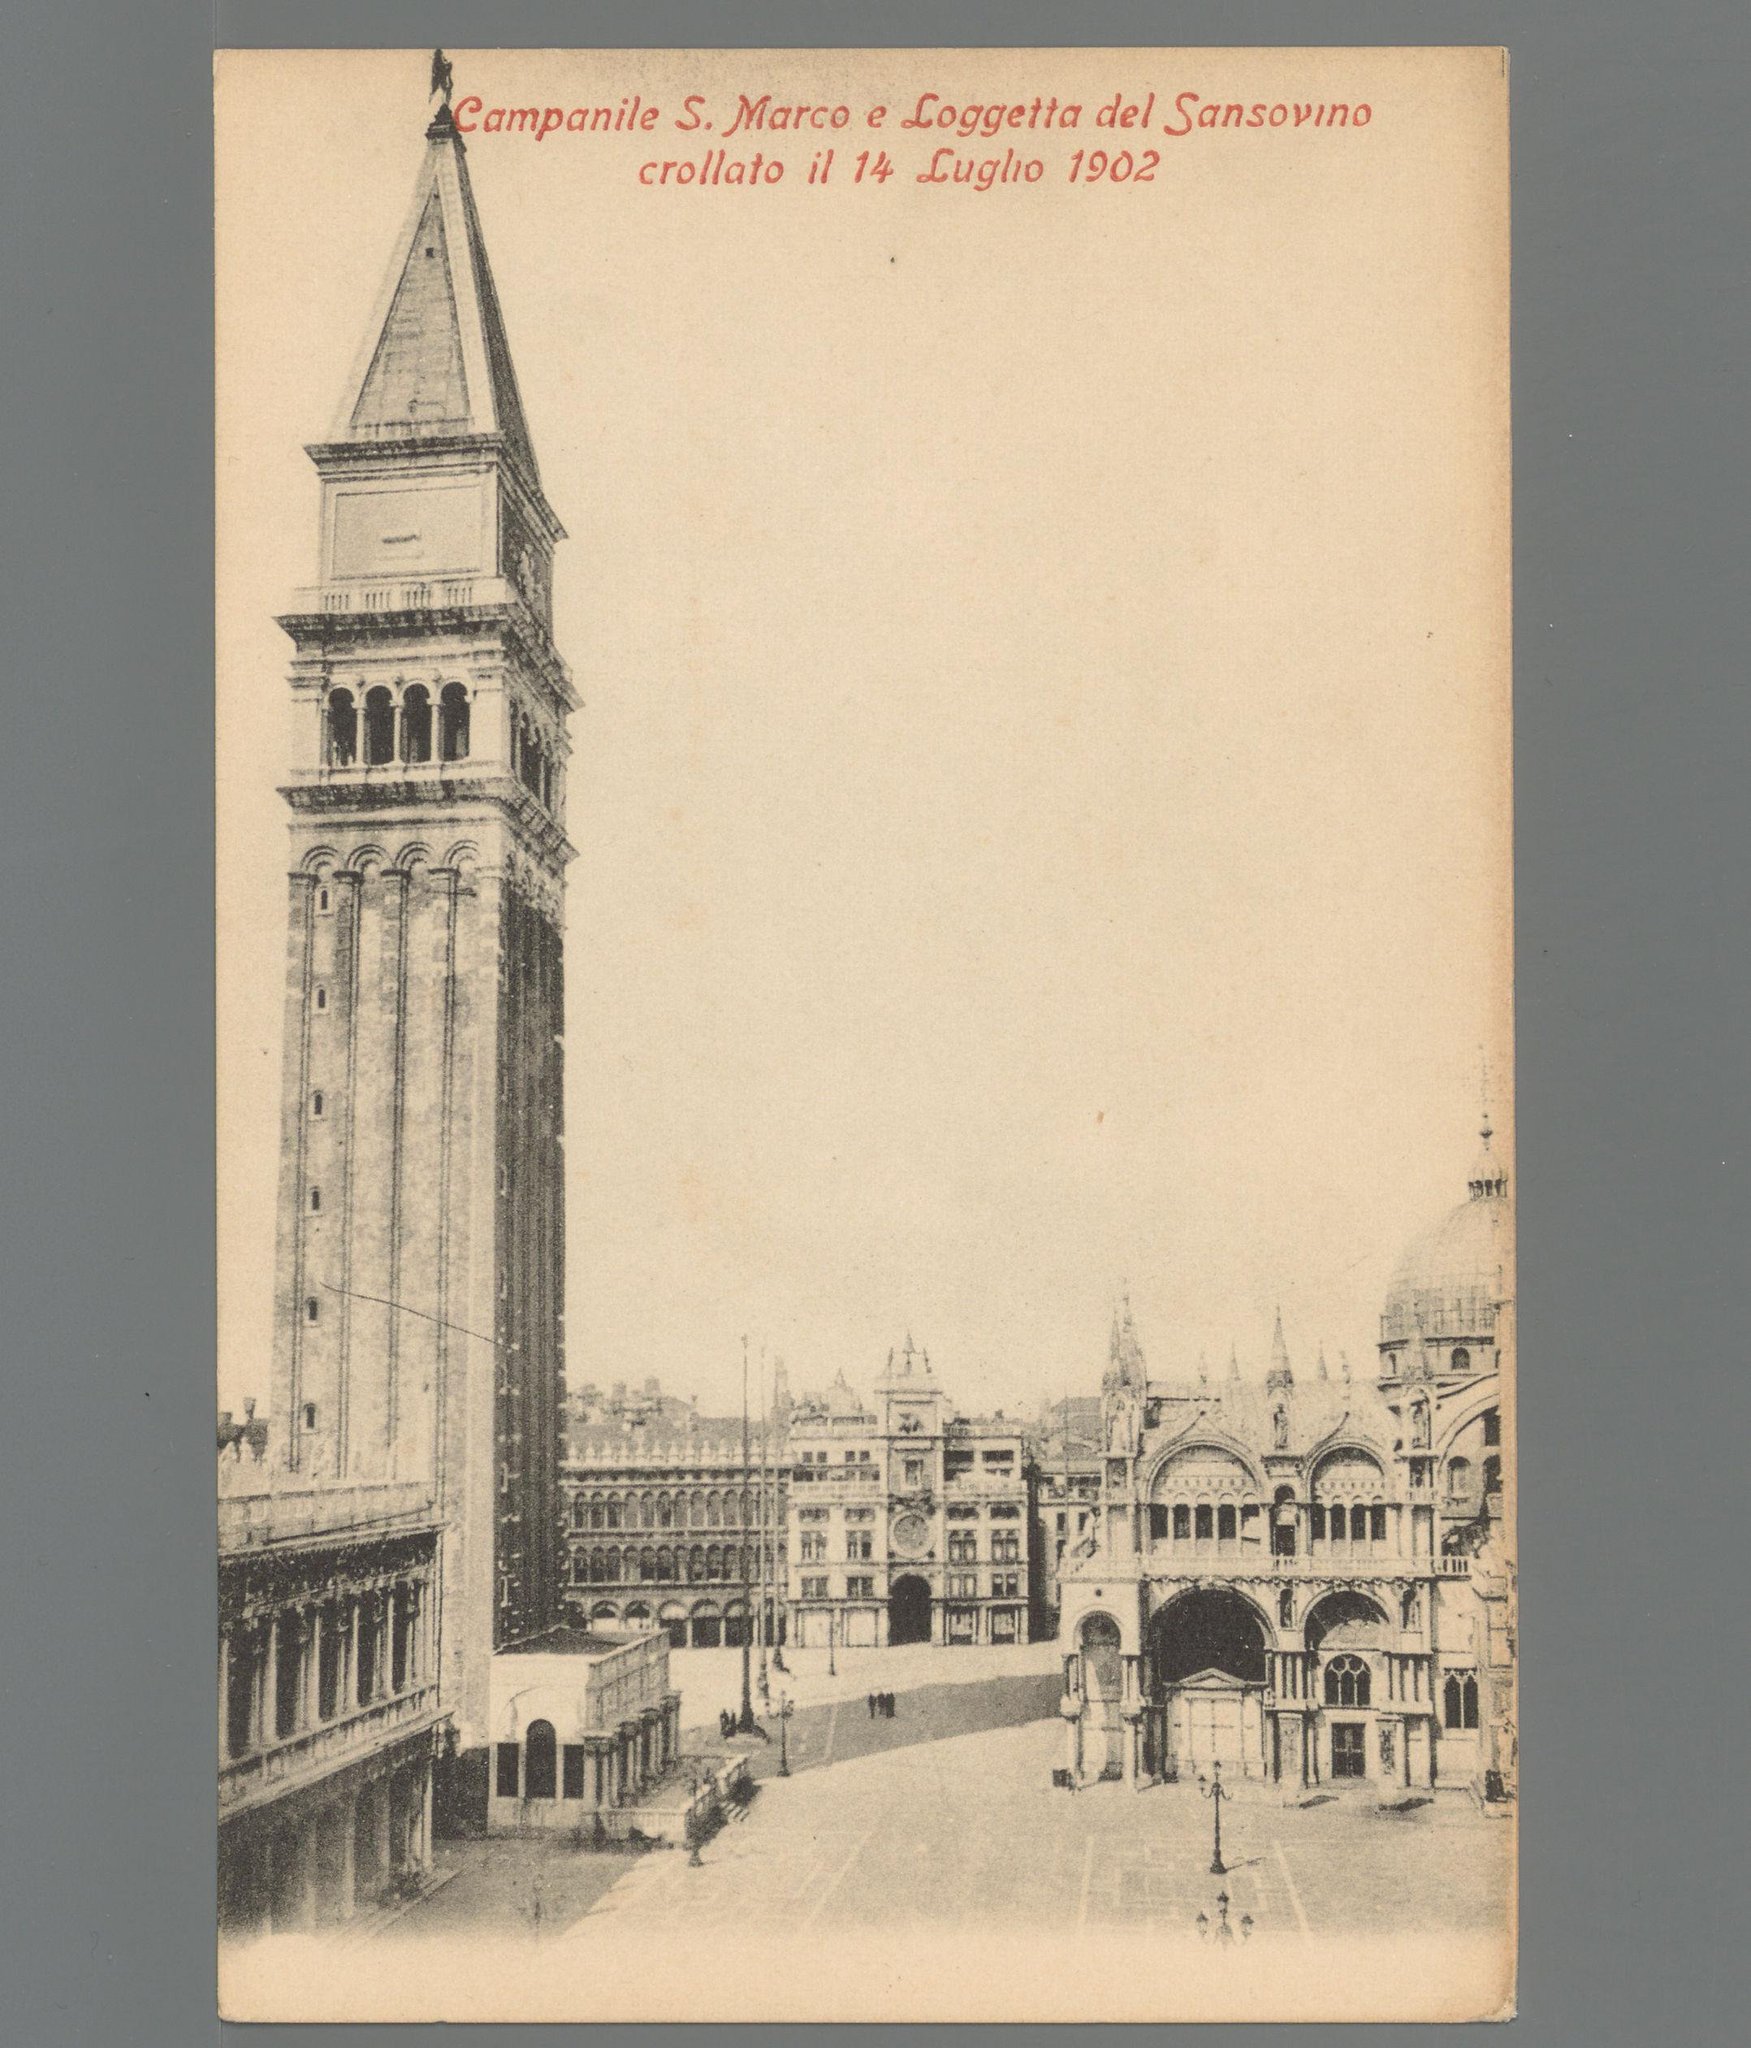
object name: photomechanical print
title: Campanile S. Marco e Loggetta del Sansovino crollato il 14 Luglio 1902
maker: Anonymous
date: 1902-1906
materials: cardboard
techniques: photograph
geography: venice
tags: tower, clock tower ~ monumental adornment, church (exterior), square, place, circus, etc. (+ city(-scape) with figures, staffage)